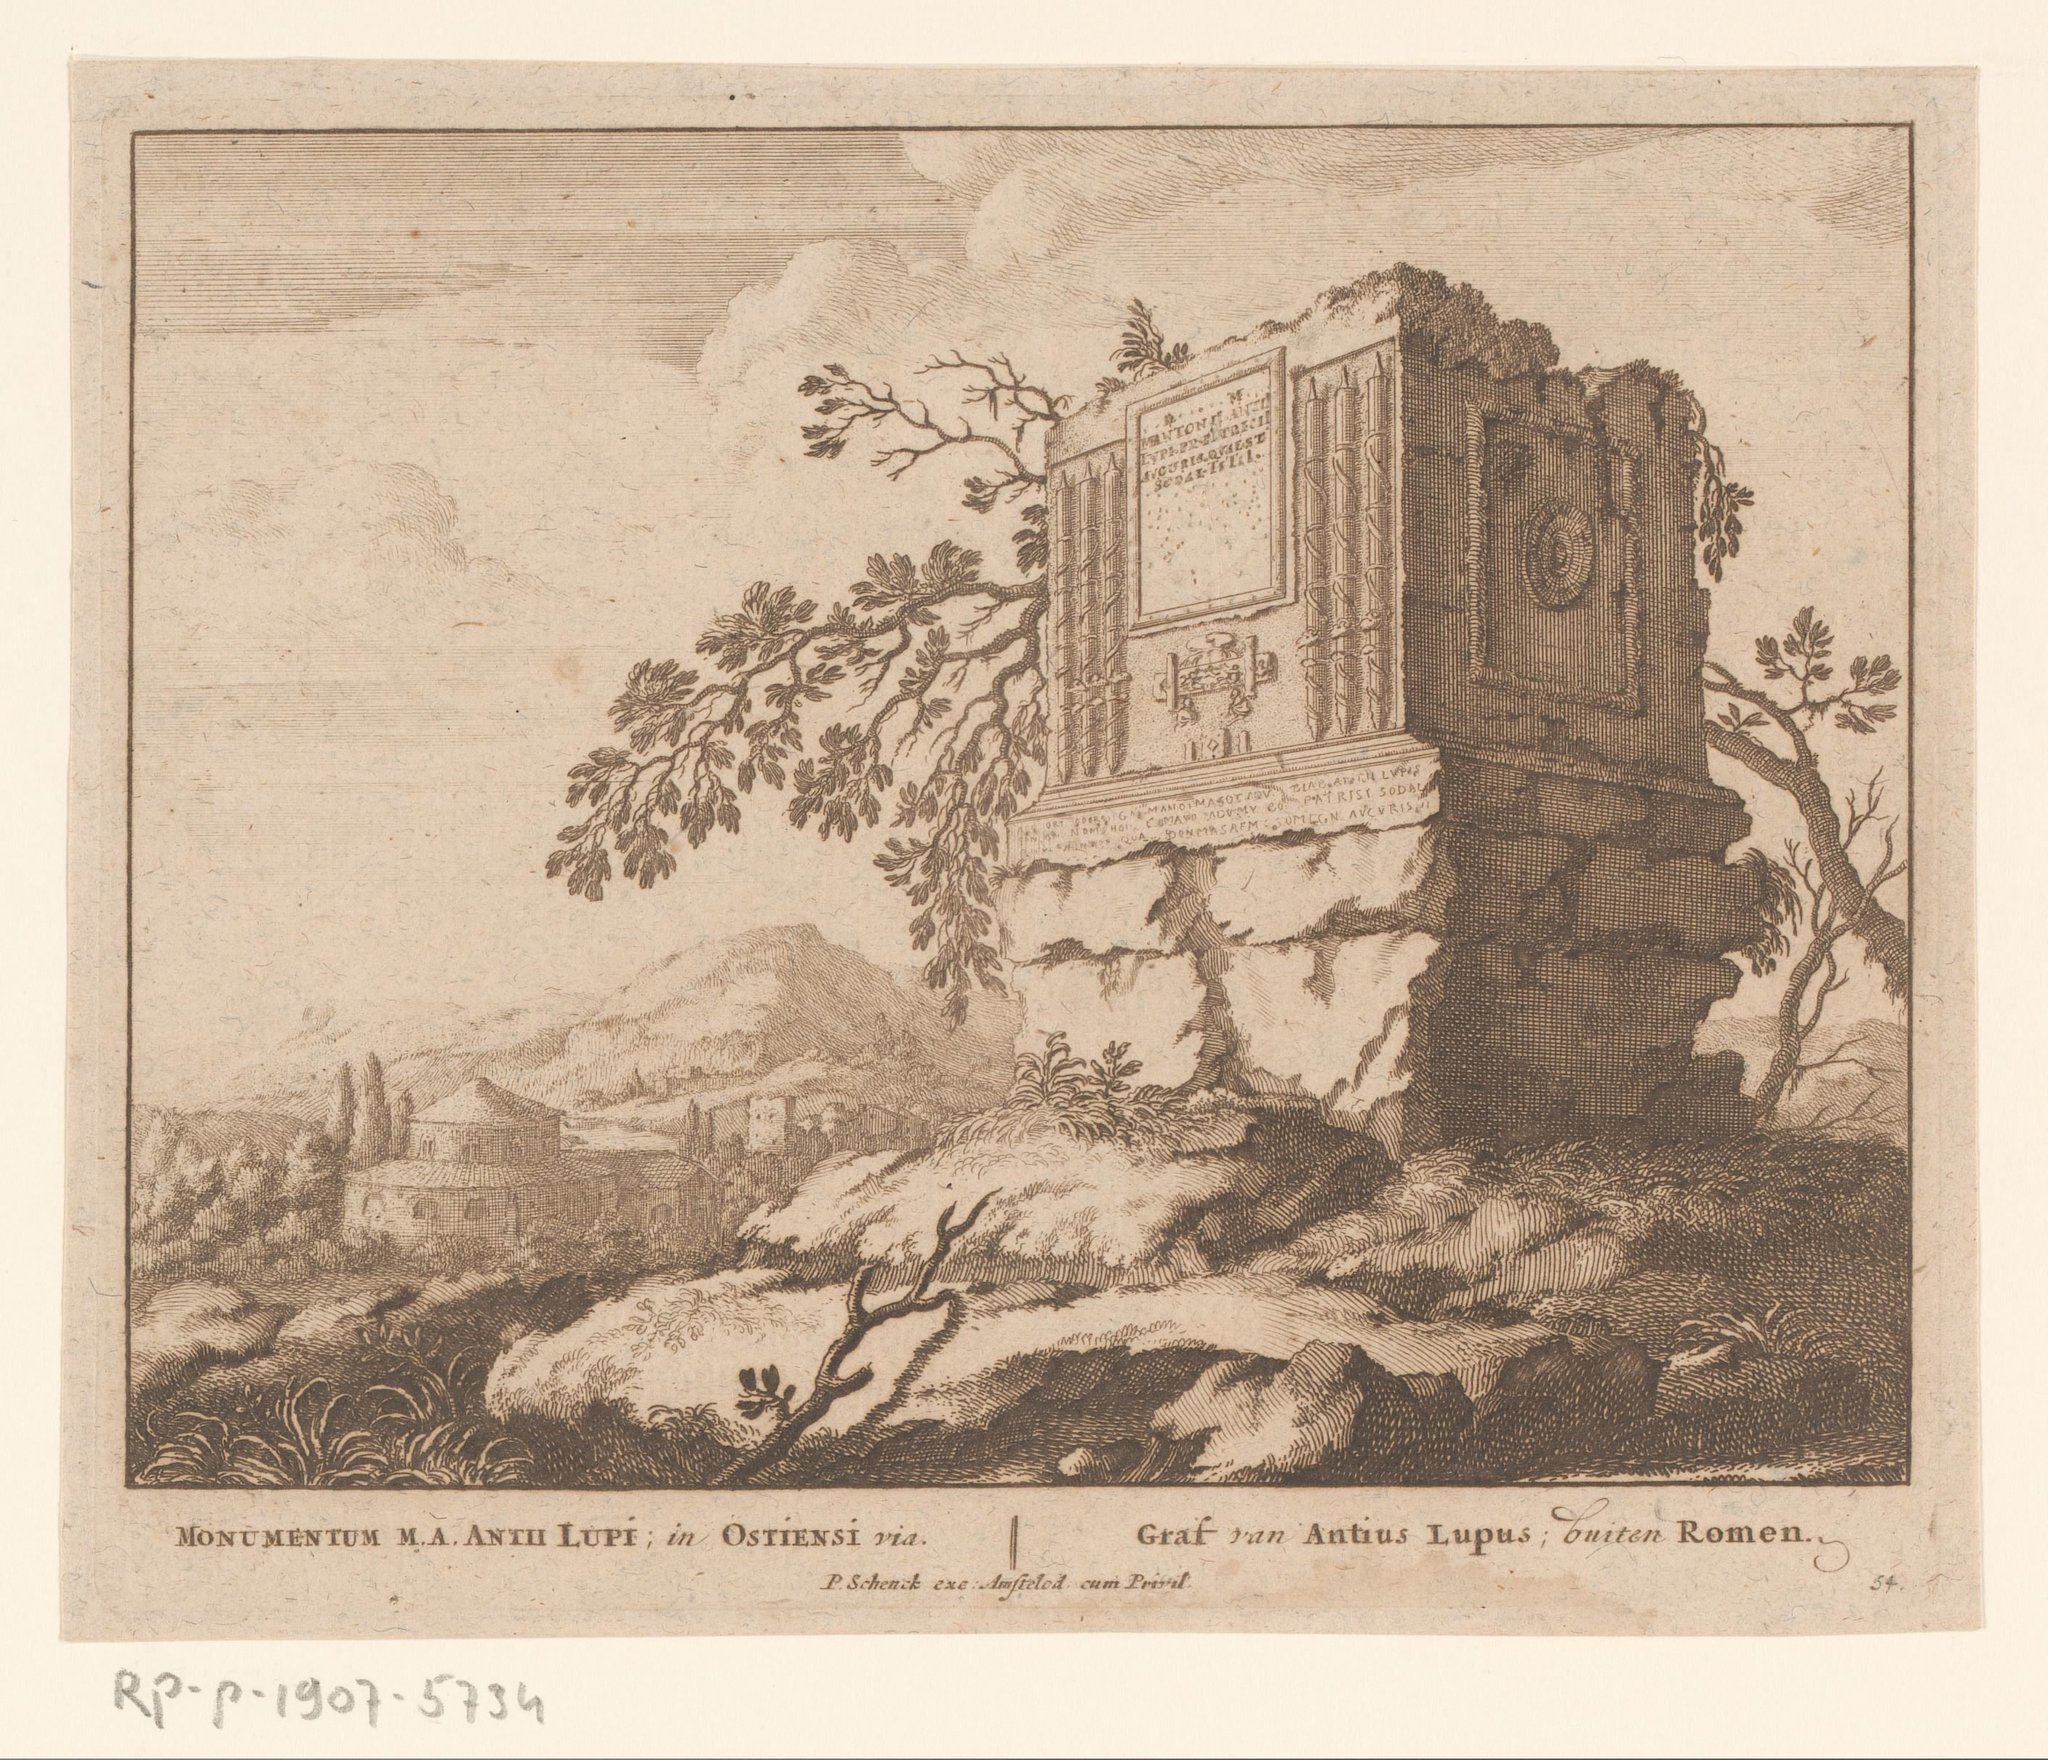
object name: print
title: Gezichten in Rome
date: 1705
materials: paper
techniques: etching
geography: amsterdam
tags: grave, tomb, rome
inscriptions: collector's mark: Lugt 2228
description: Prent ook gebruikt in: Schenck, Pieter. Roma aeterna Petri Schenkii, sive, ipsius Aedificiorum romanorum, integrorum collapsorumque (...). Amsterdam: Pieter Schenck (I), 1705.